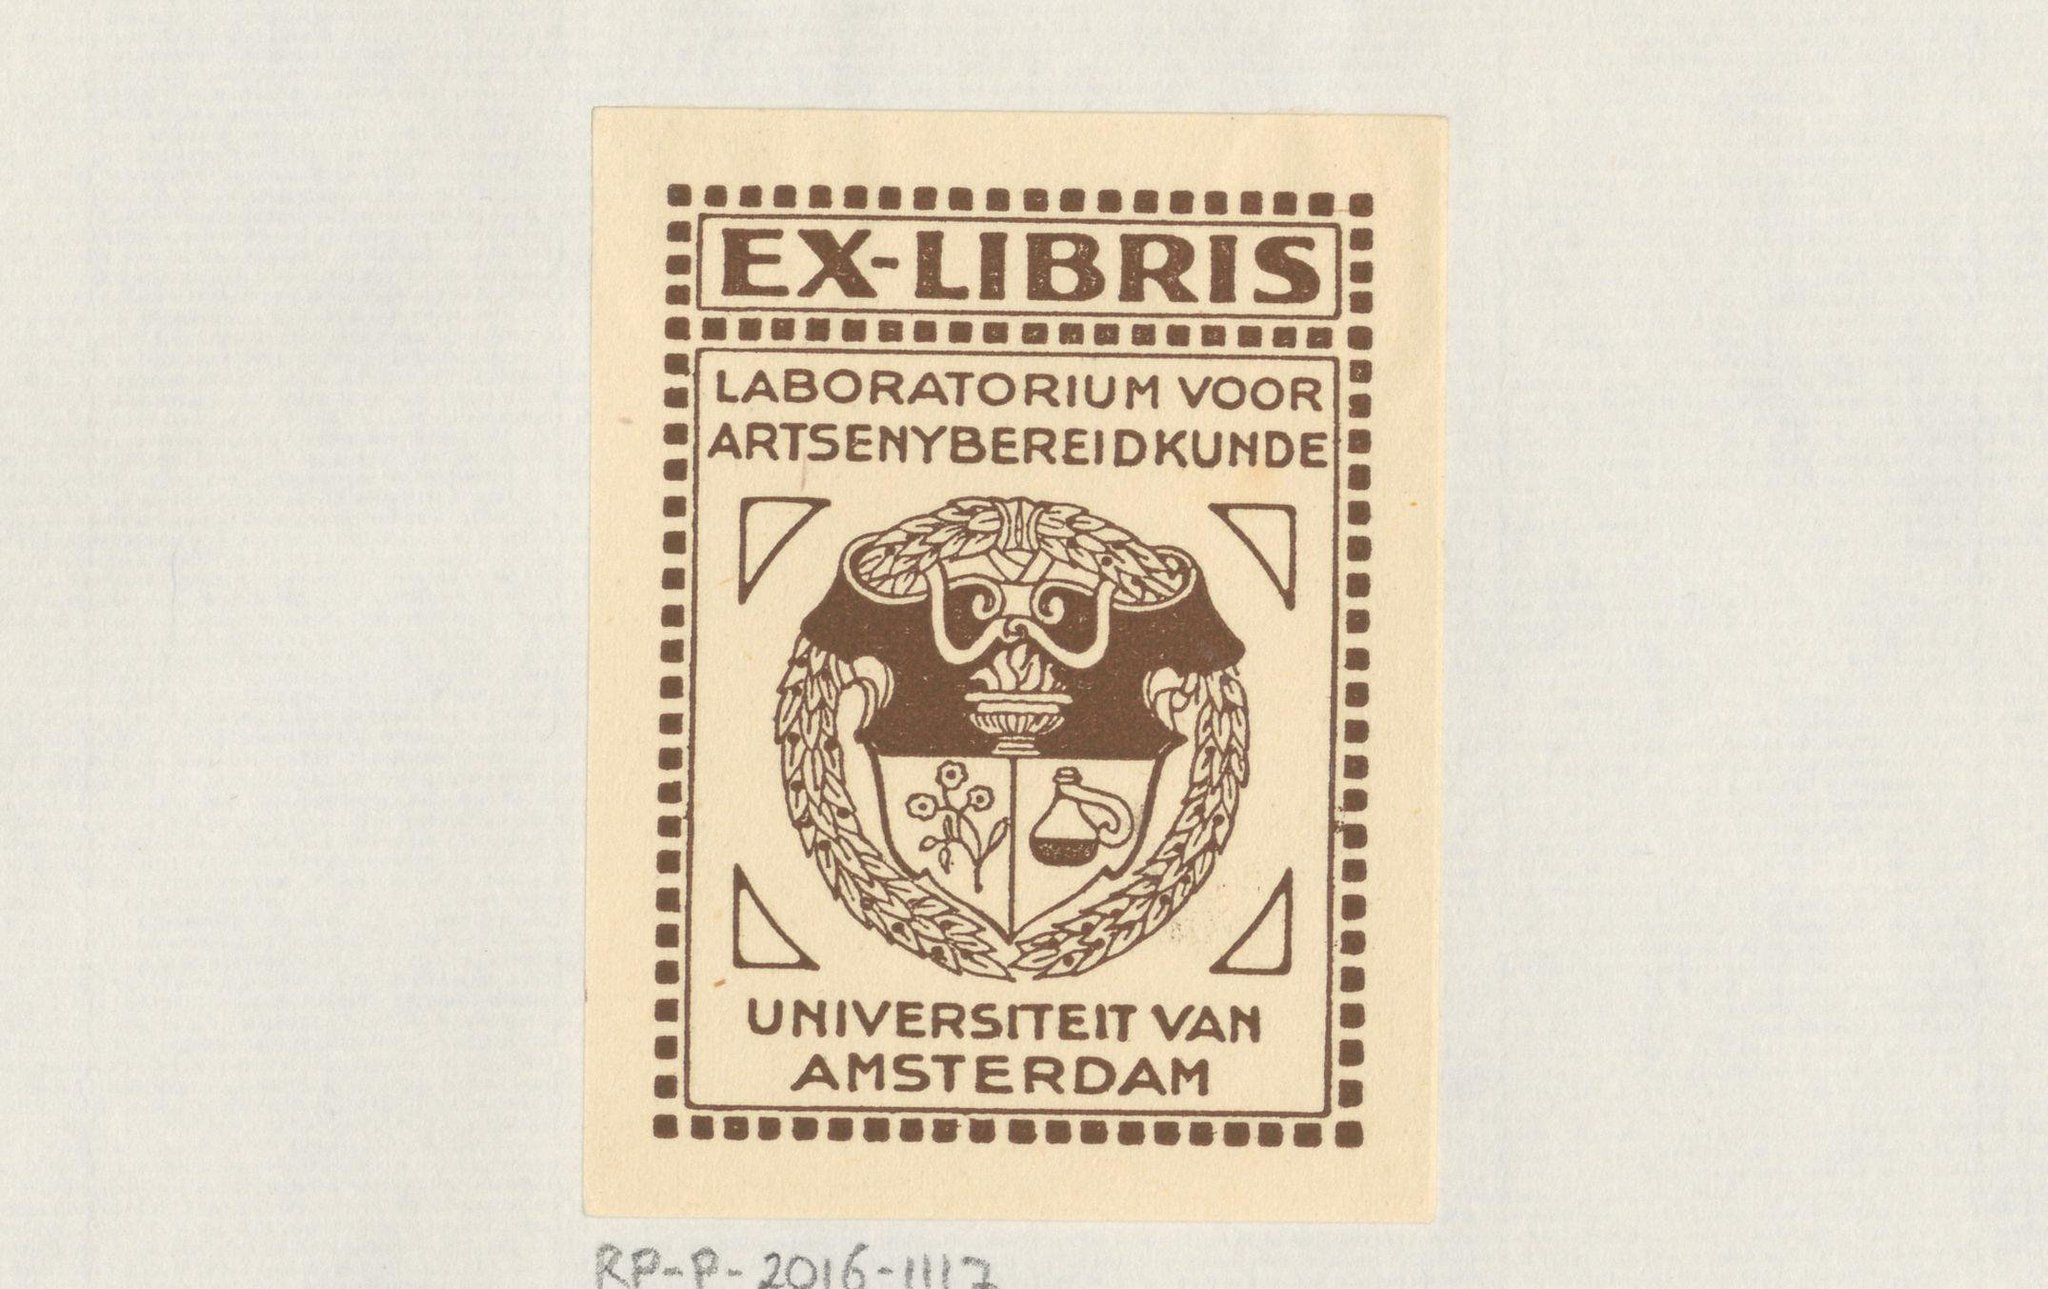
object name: bookplate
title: Ex libris van het laboratorium voor artsenijbereidkunde, Universiteit van Amsterdam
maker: Anonymous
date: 1925-1960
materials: paper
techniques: printing block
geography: netherlands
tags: pharmacy, pharmaceutics